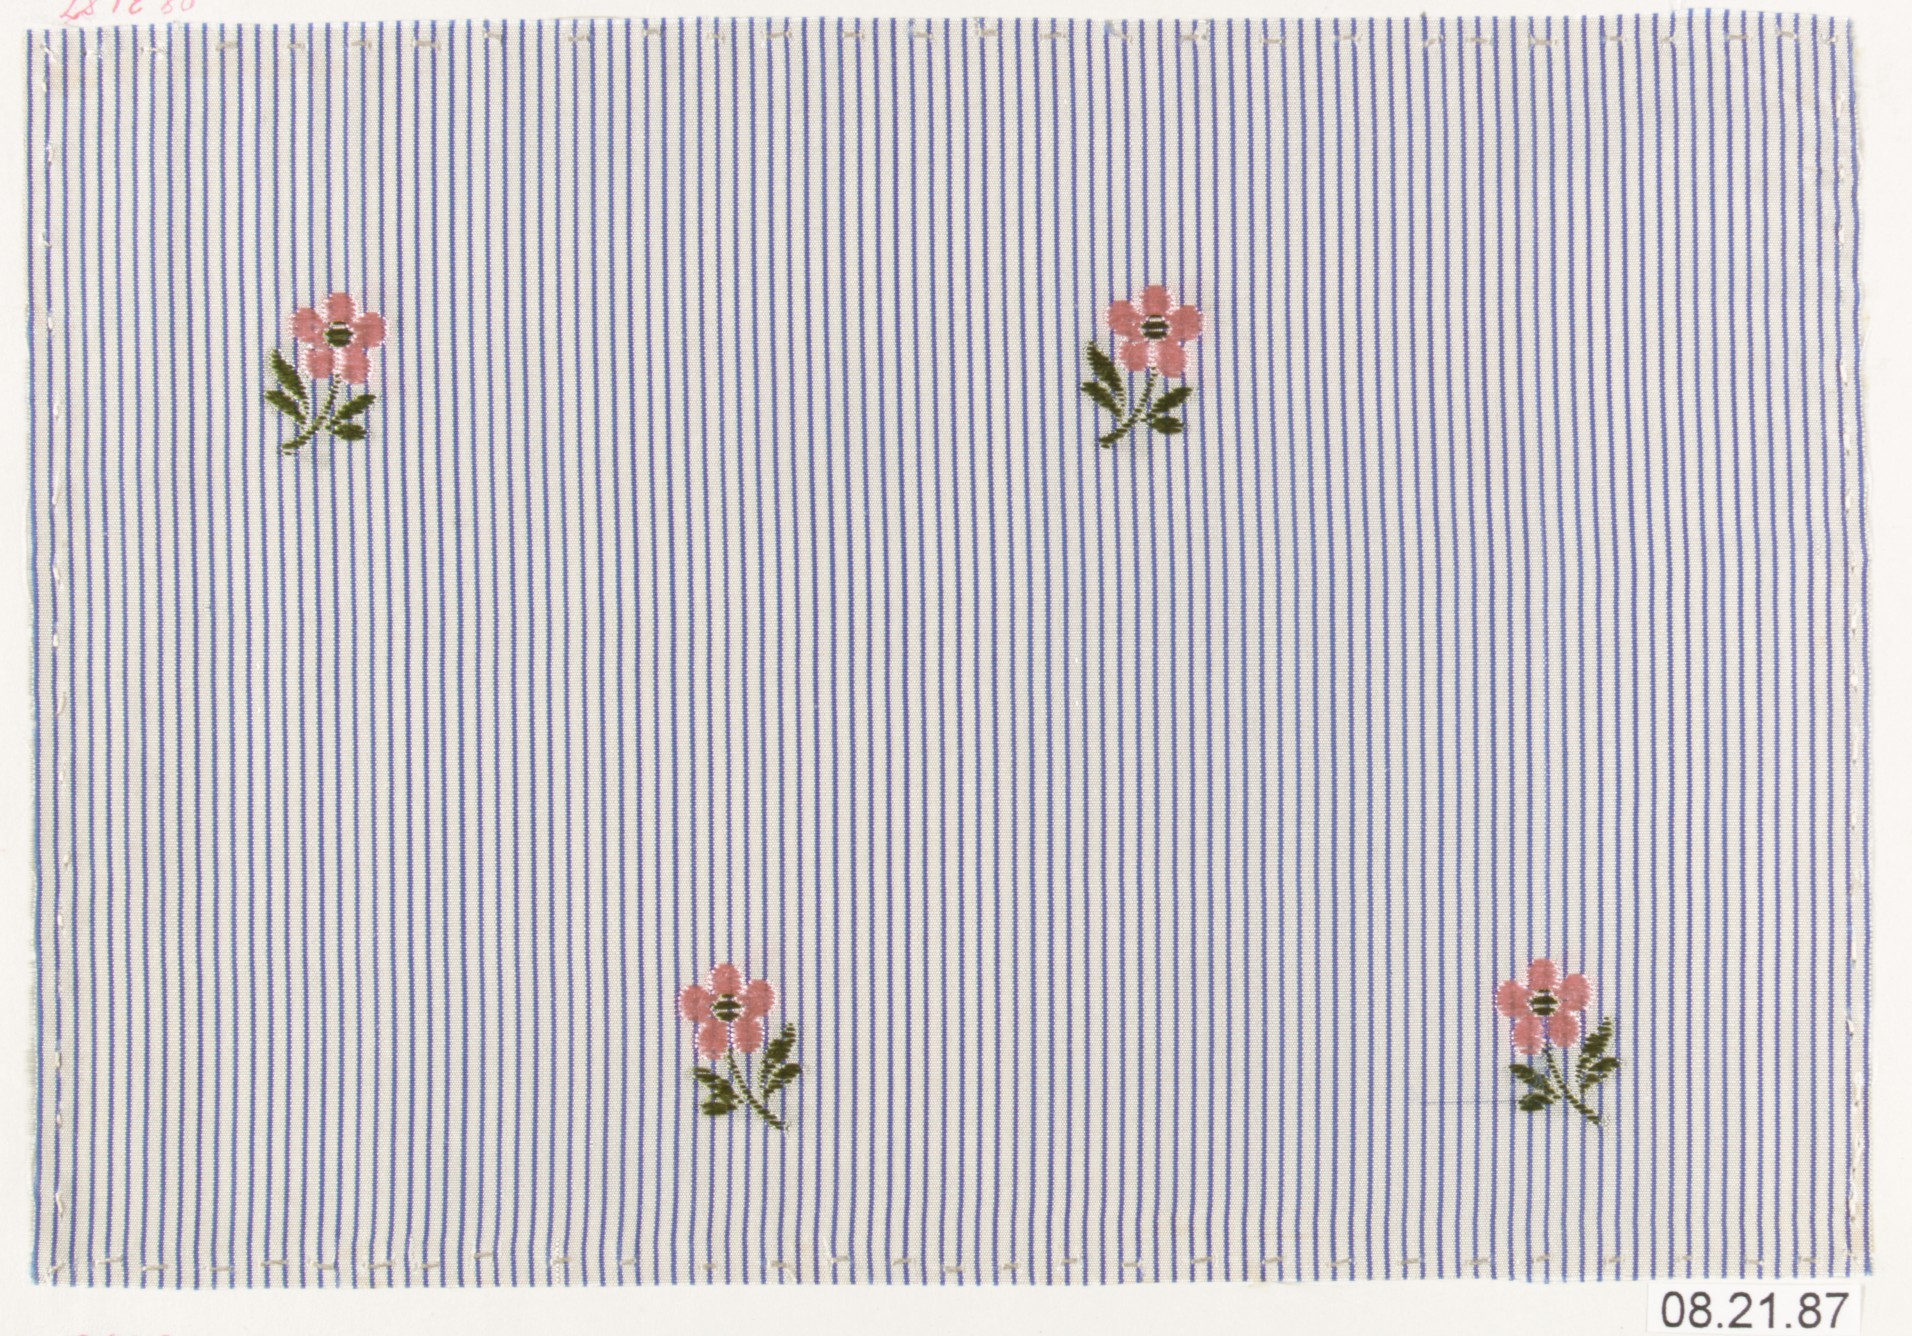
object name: textile sample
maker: Anonymous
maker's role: designer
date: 1900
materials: silk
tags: flowers